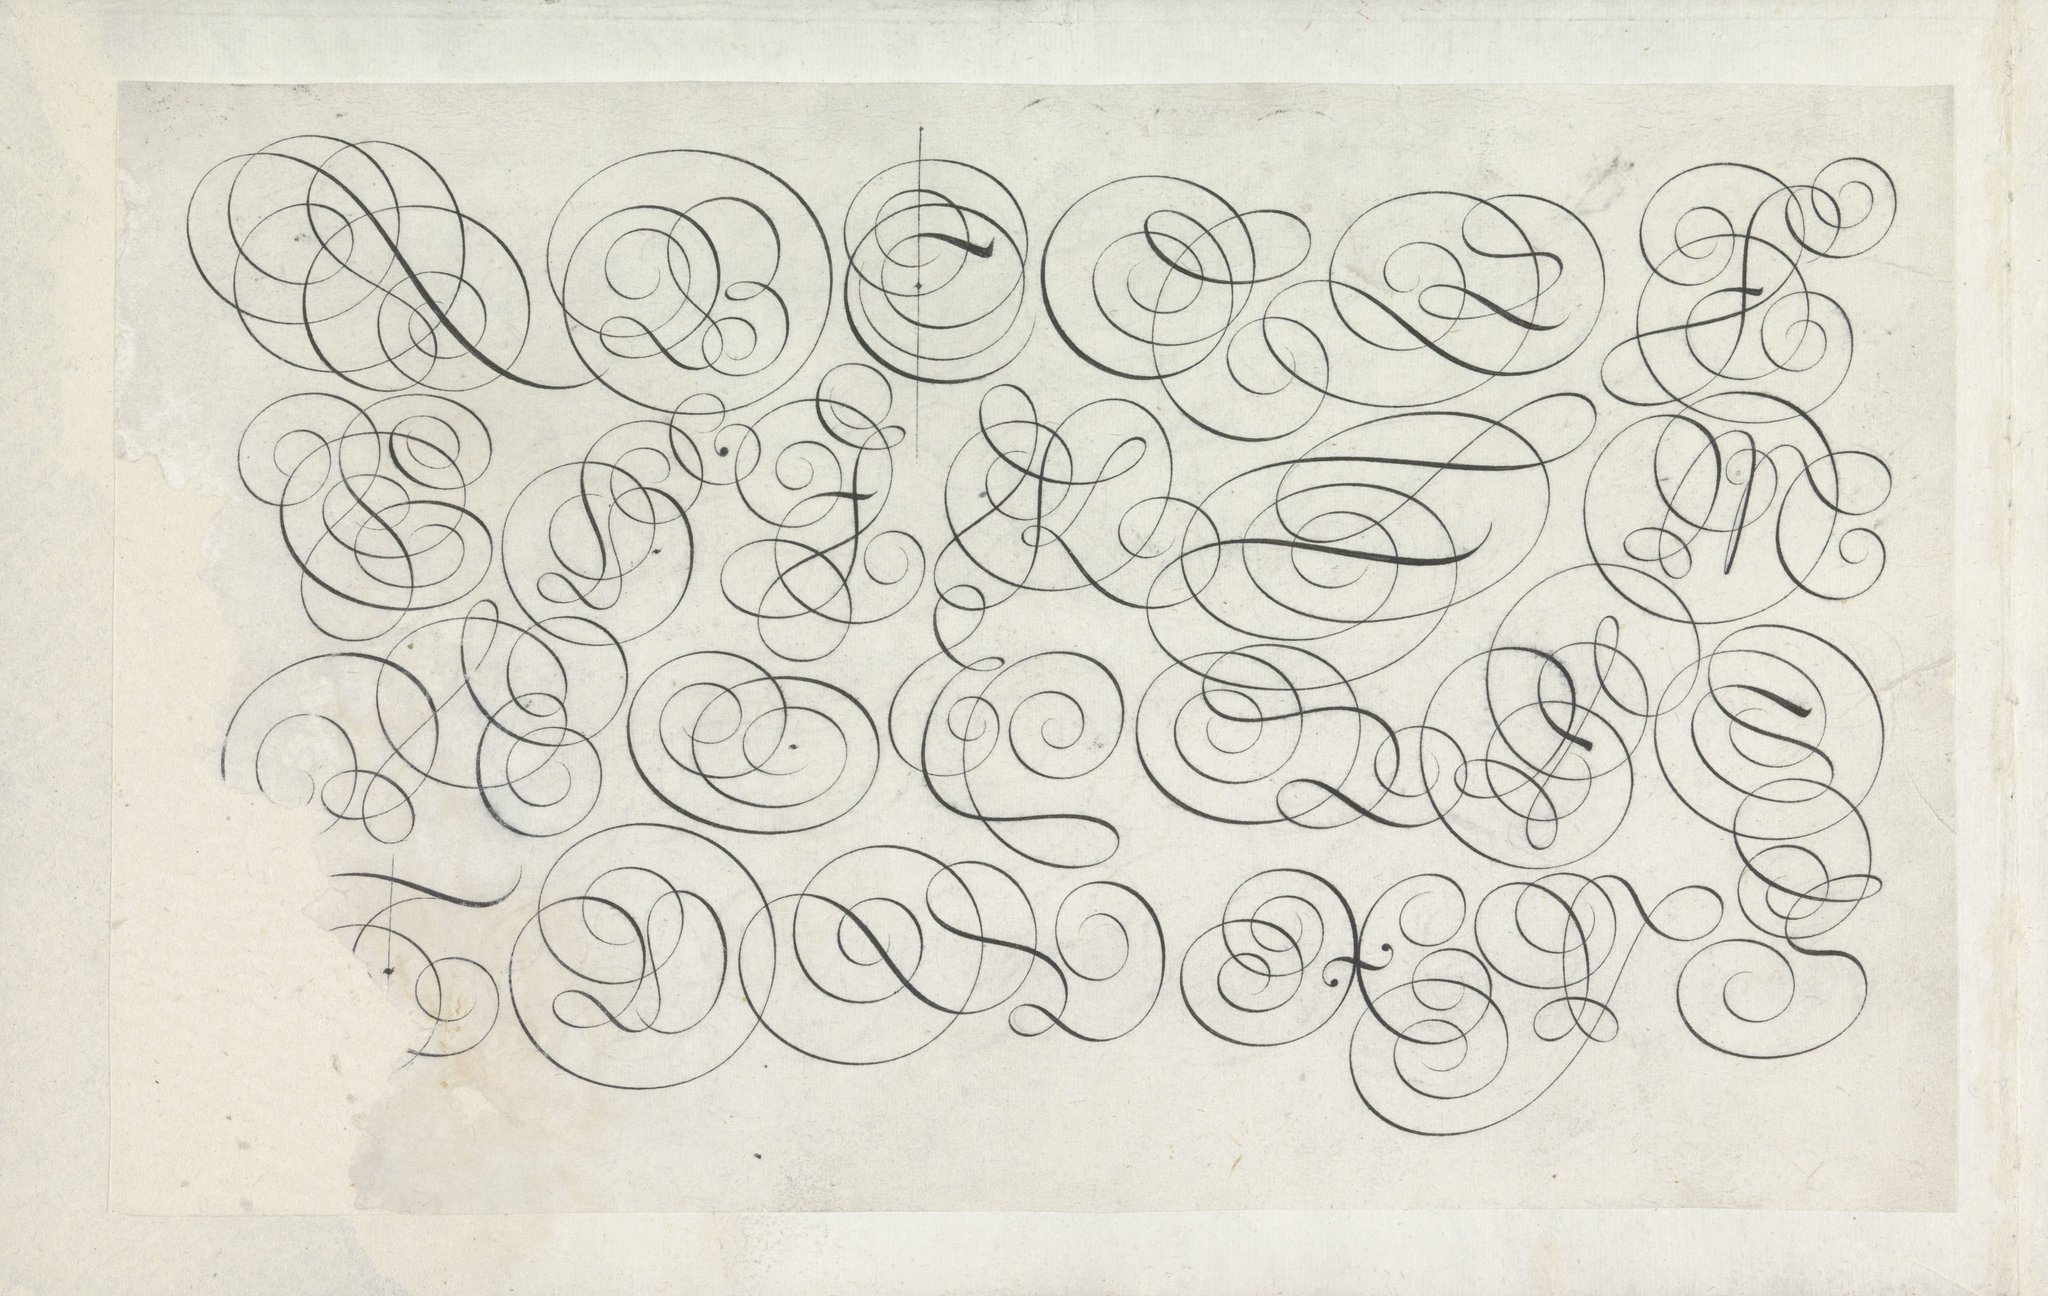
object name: album leaf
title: Spieghel der schrijfkonste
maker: jan van de velde (i)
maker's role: painter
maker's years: 1568-1623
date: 1605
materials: ink, paper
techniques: calligraphy, pen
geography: rotterdam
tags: calligraphy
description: Kalligrafische tekening met het alfabet in vier regels kapitalen. De tekening maken deel uit van een album.